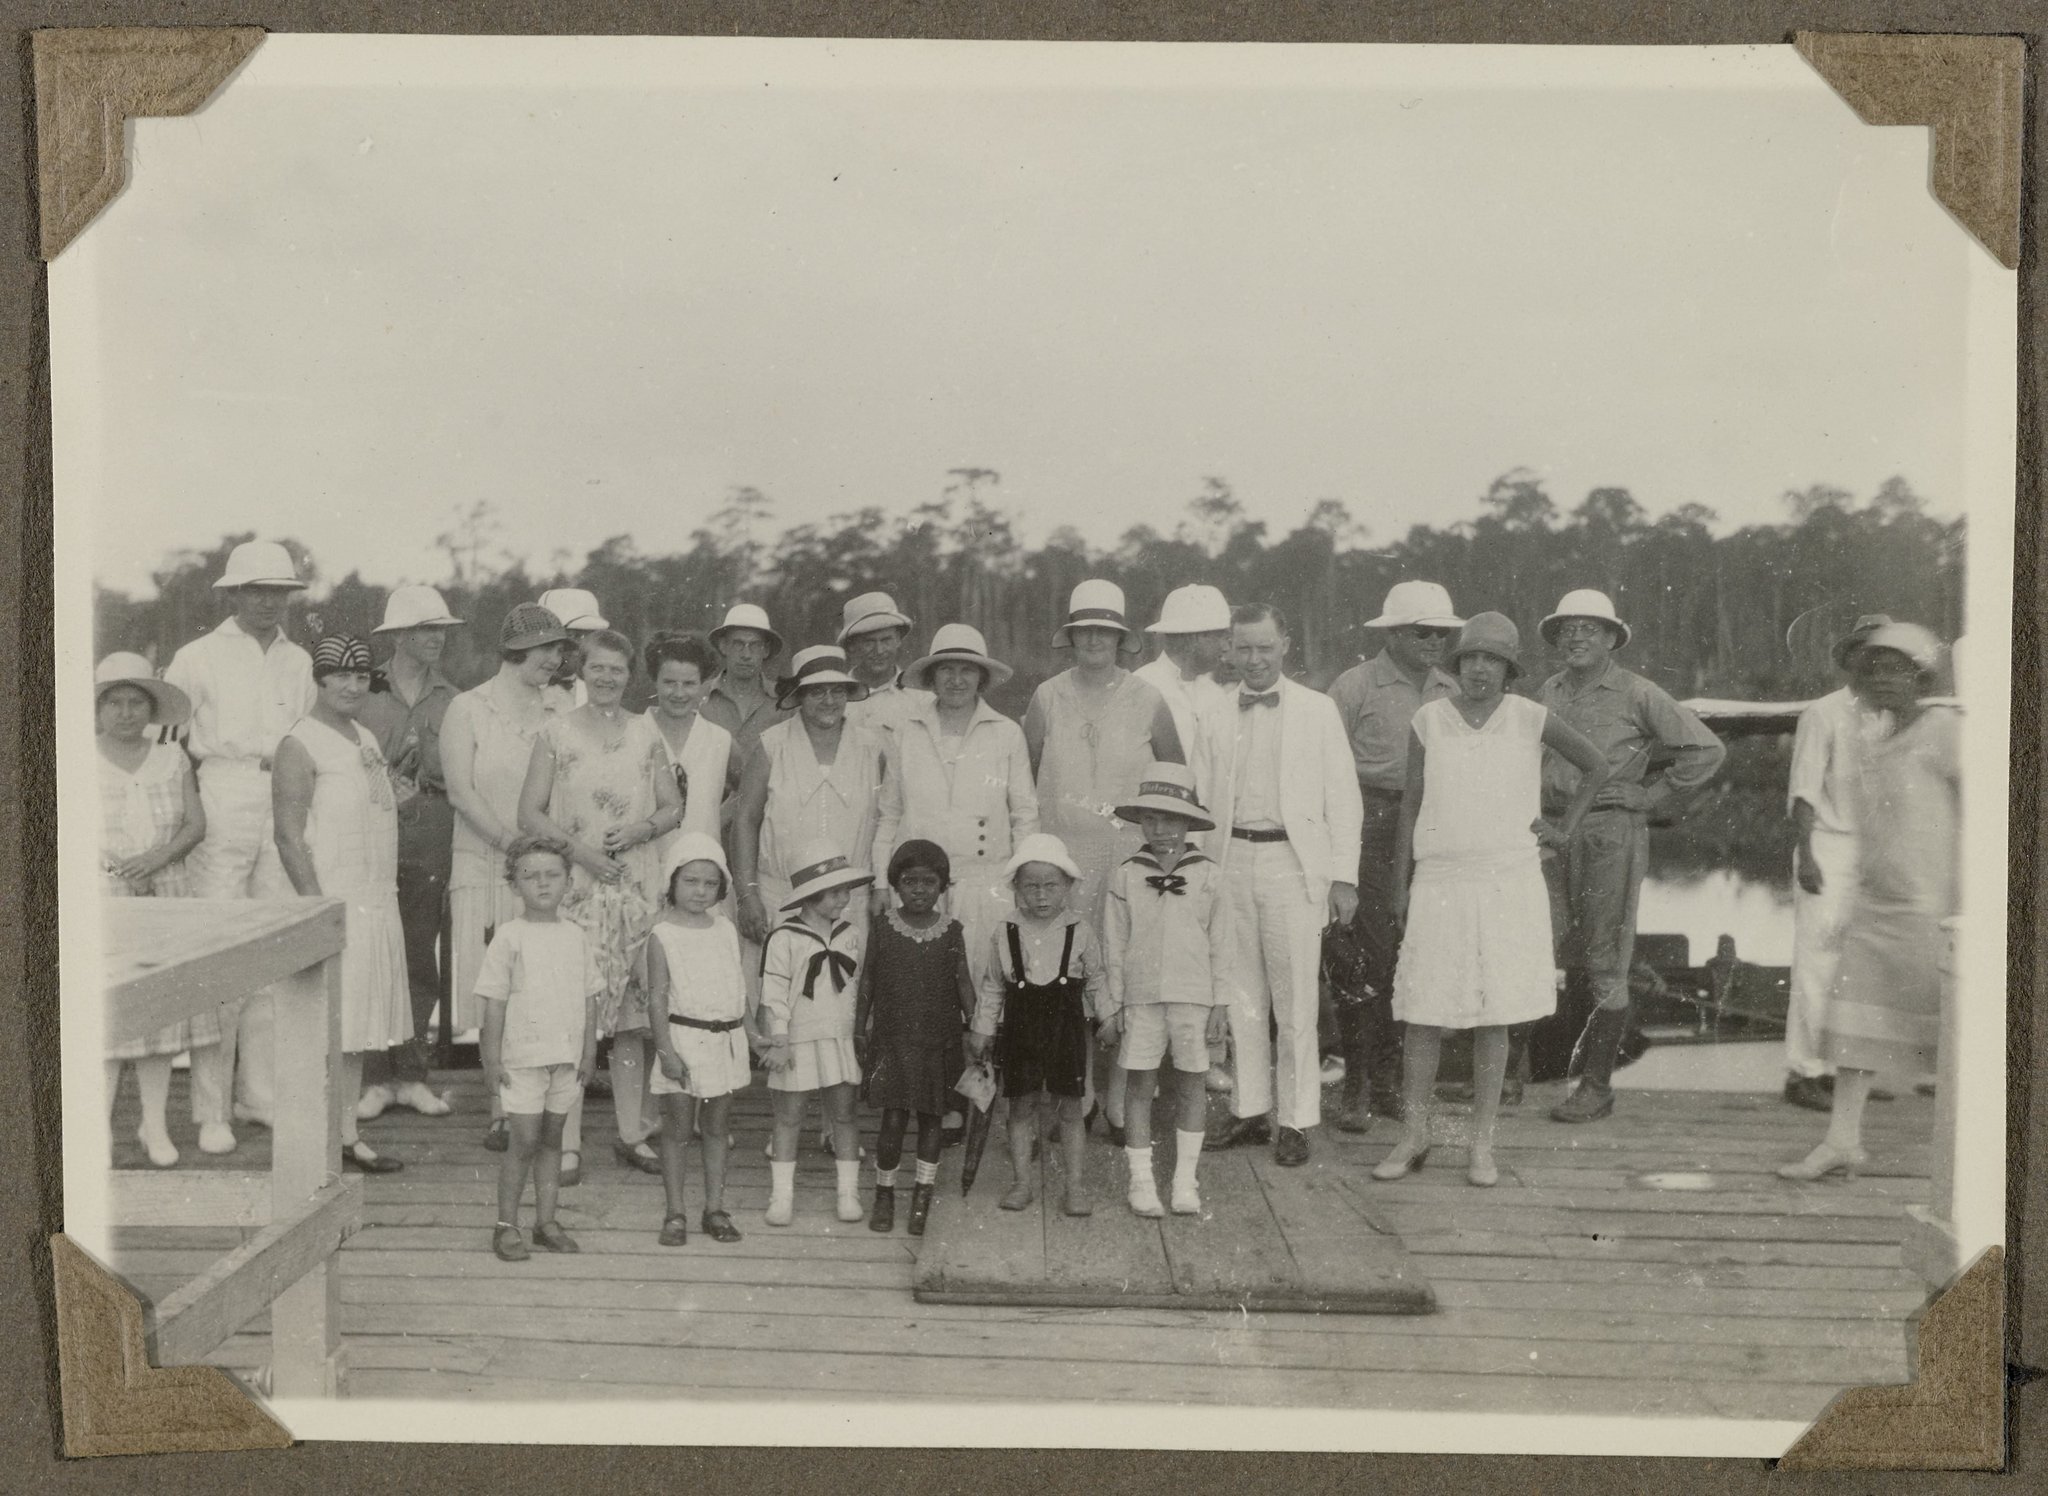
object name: photograph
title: Groepsfoto op de tennisclub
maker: Anonymous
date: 1925-1927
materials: photographic support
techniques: photography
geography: suriname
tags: tennis, lawn-tennis, anonymous historical persons portrayed in a group, in a group-portrait, suriname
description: Groepsfoto op de tennisclub met Edith Jetten. Foto met hoekjes bevestigd op een bladzijde van een albumblad in het fotoalbum over de familie Jetten en het leven en werken in de mijnstad Moengo in Suriname rond 1927.